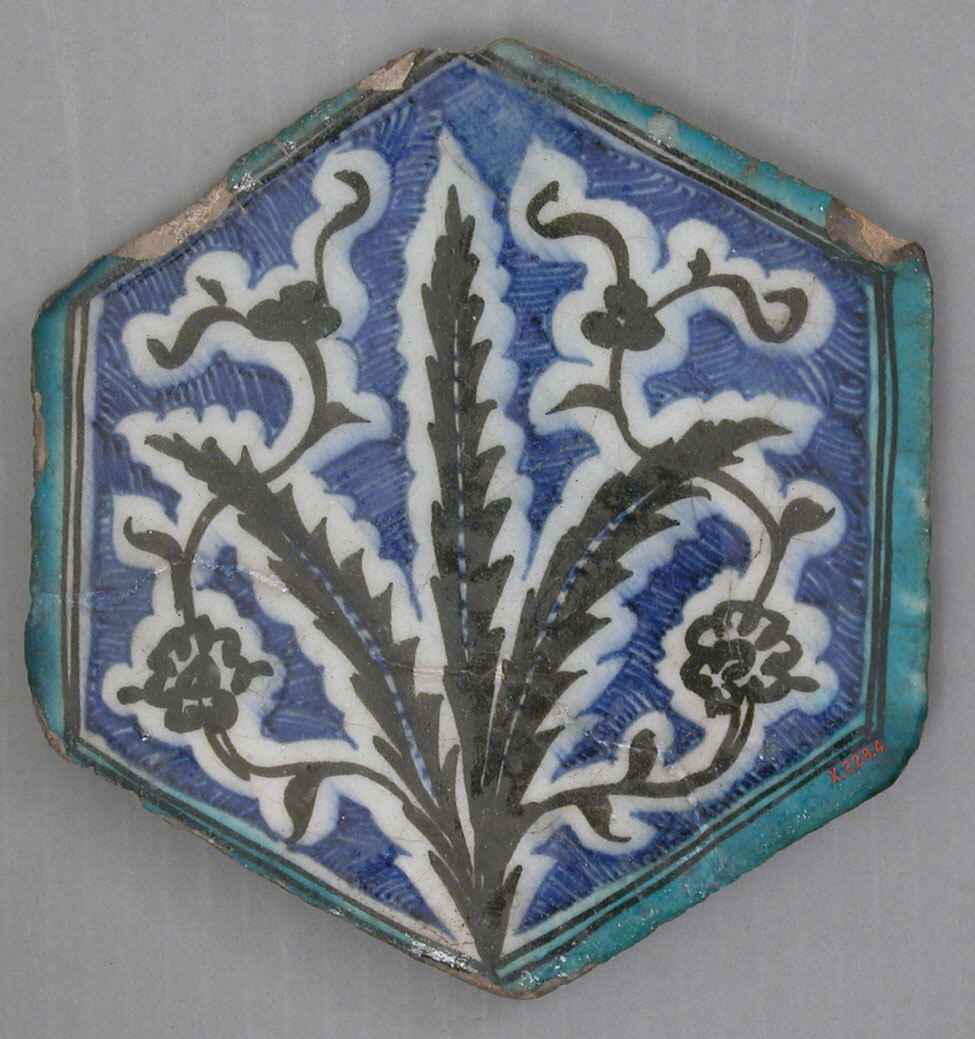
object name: tile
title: Hexagonal Tile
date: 1401-1600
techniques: glazing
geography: egypt or syria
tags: flowers